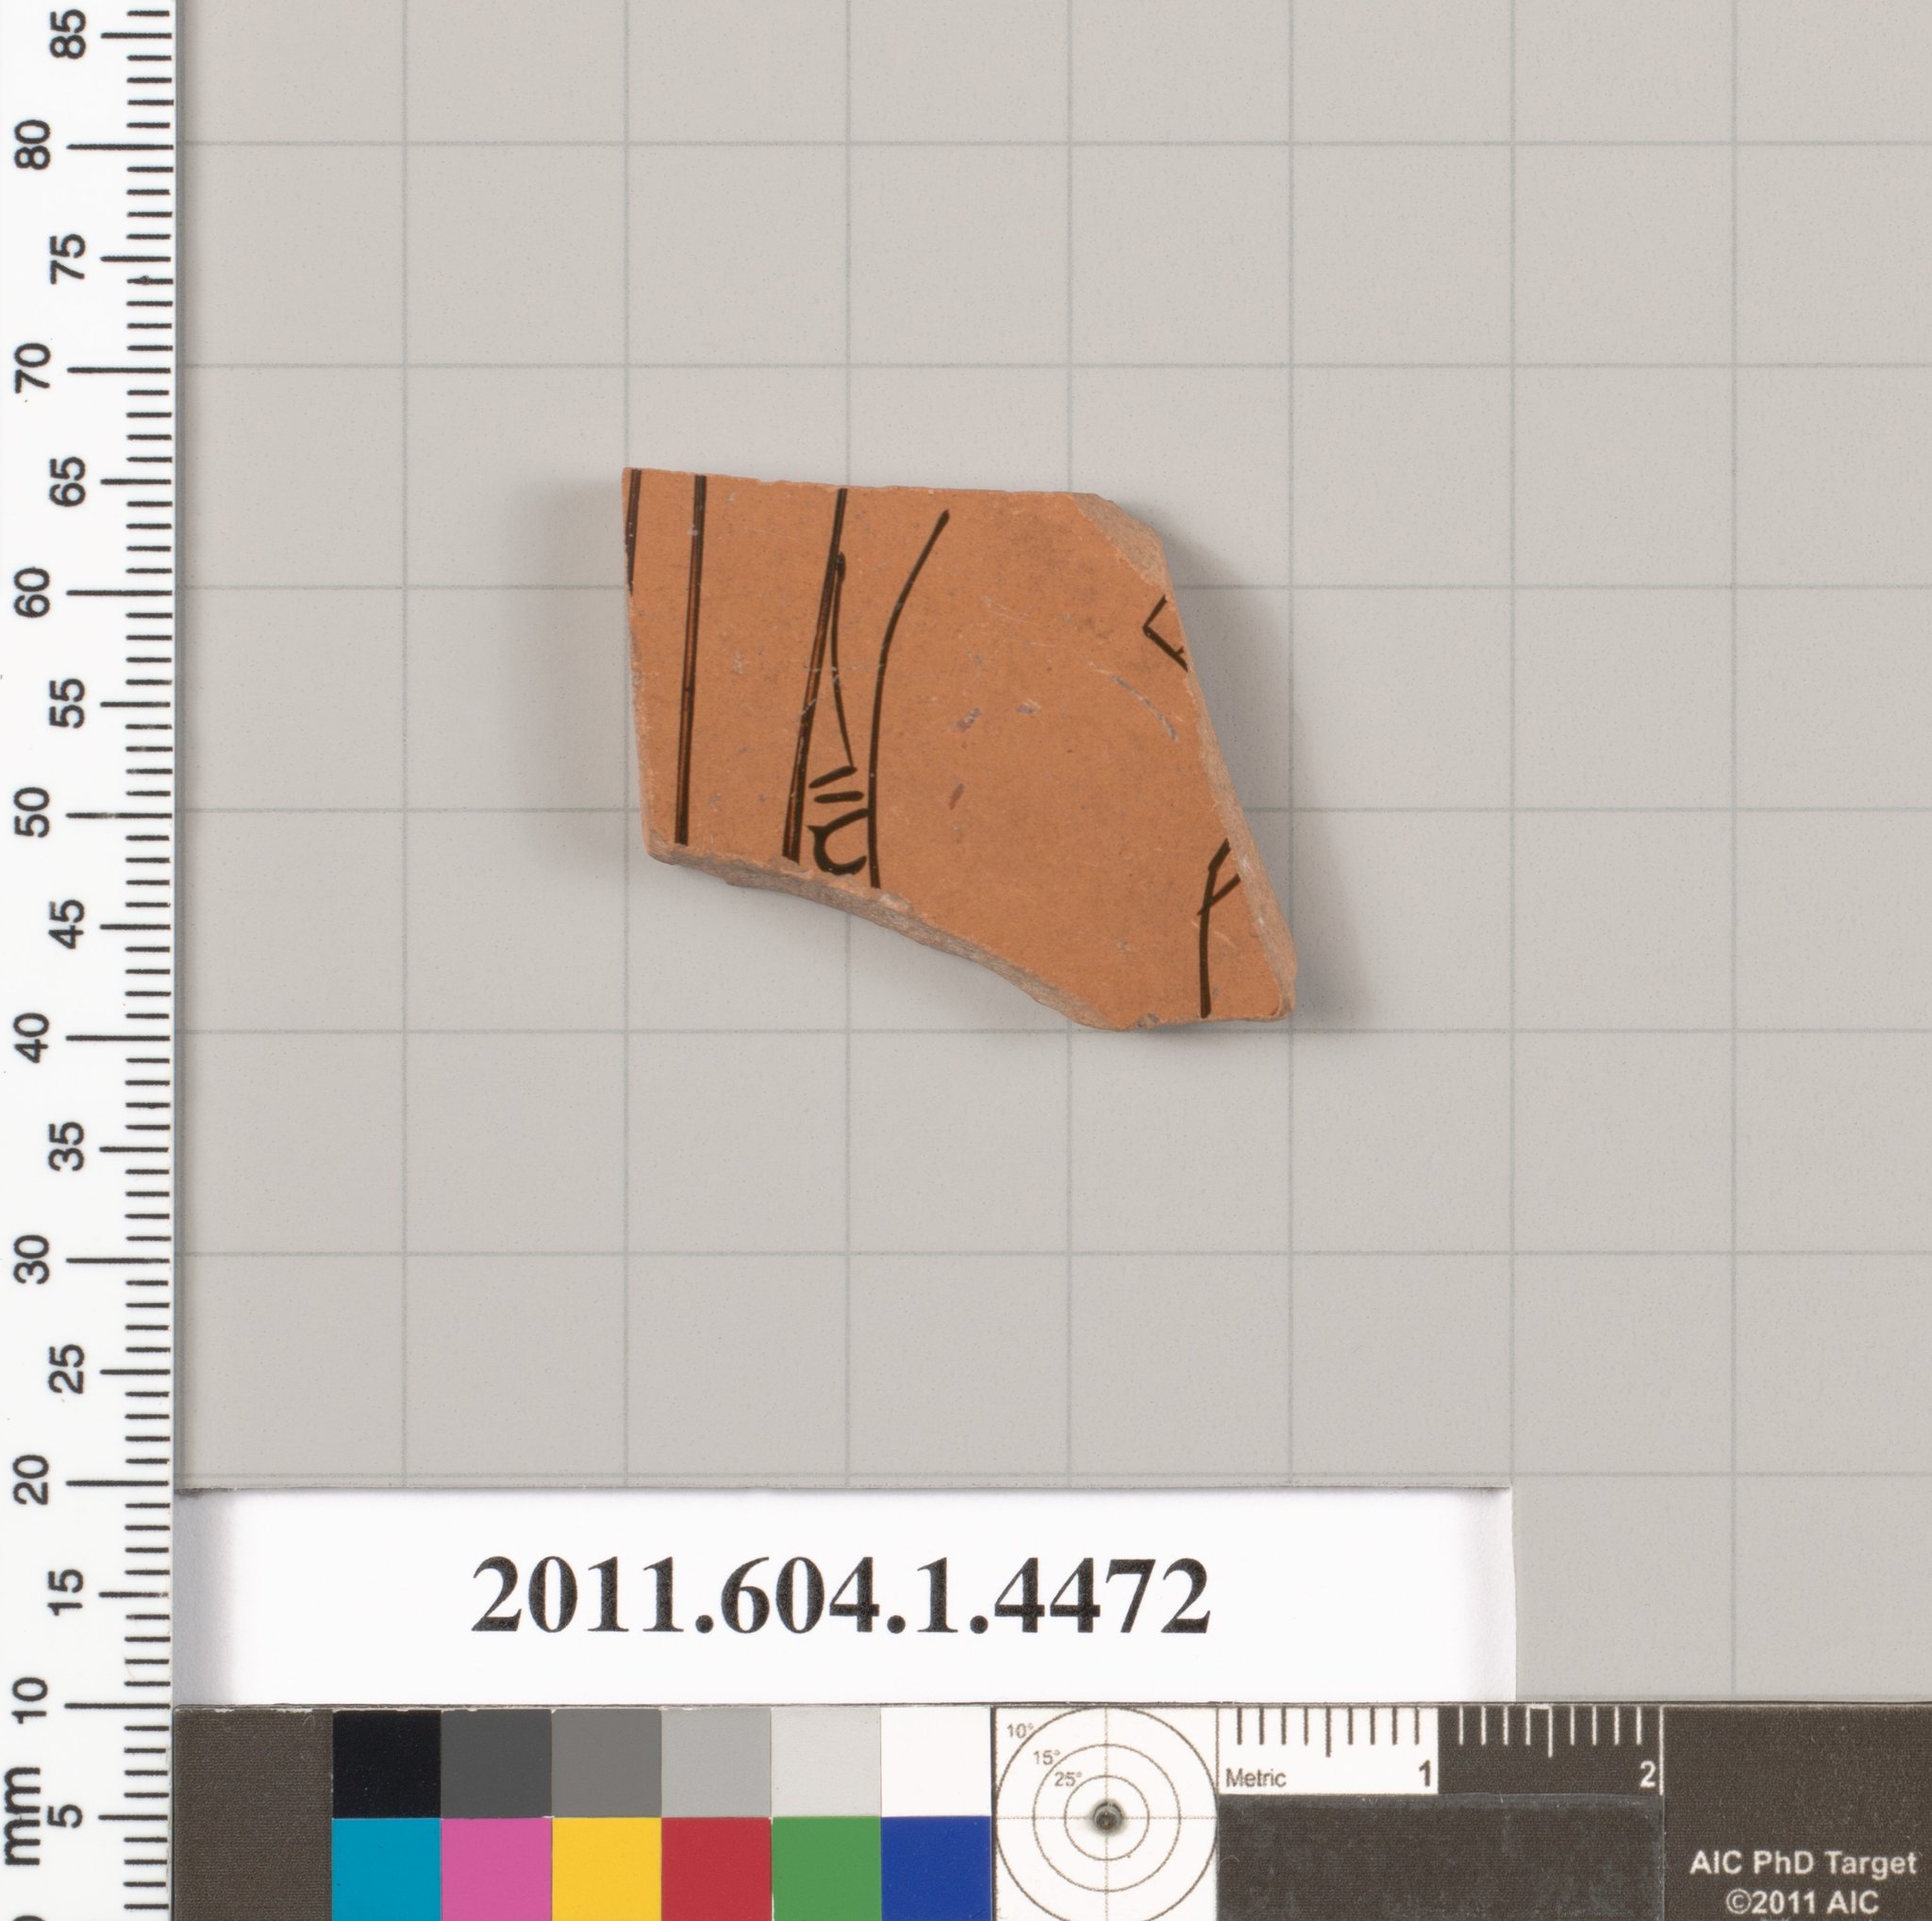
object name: kylix fragment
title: Terracotta fragment of a kylix (drinking cup)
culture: greek, attic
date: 490-470 BCE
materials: terracotta